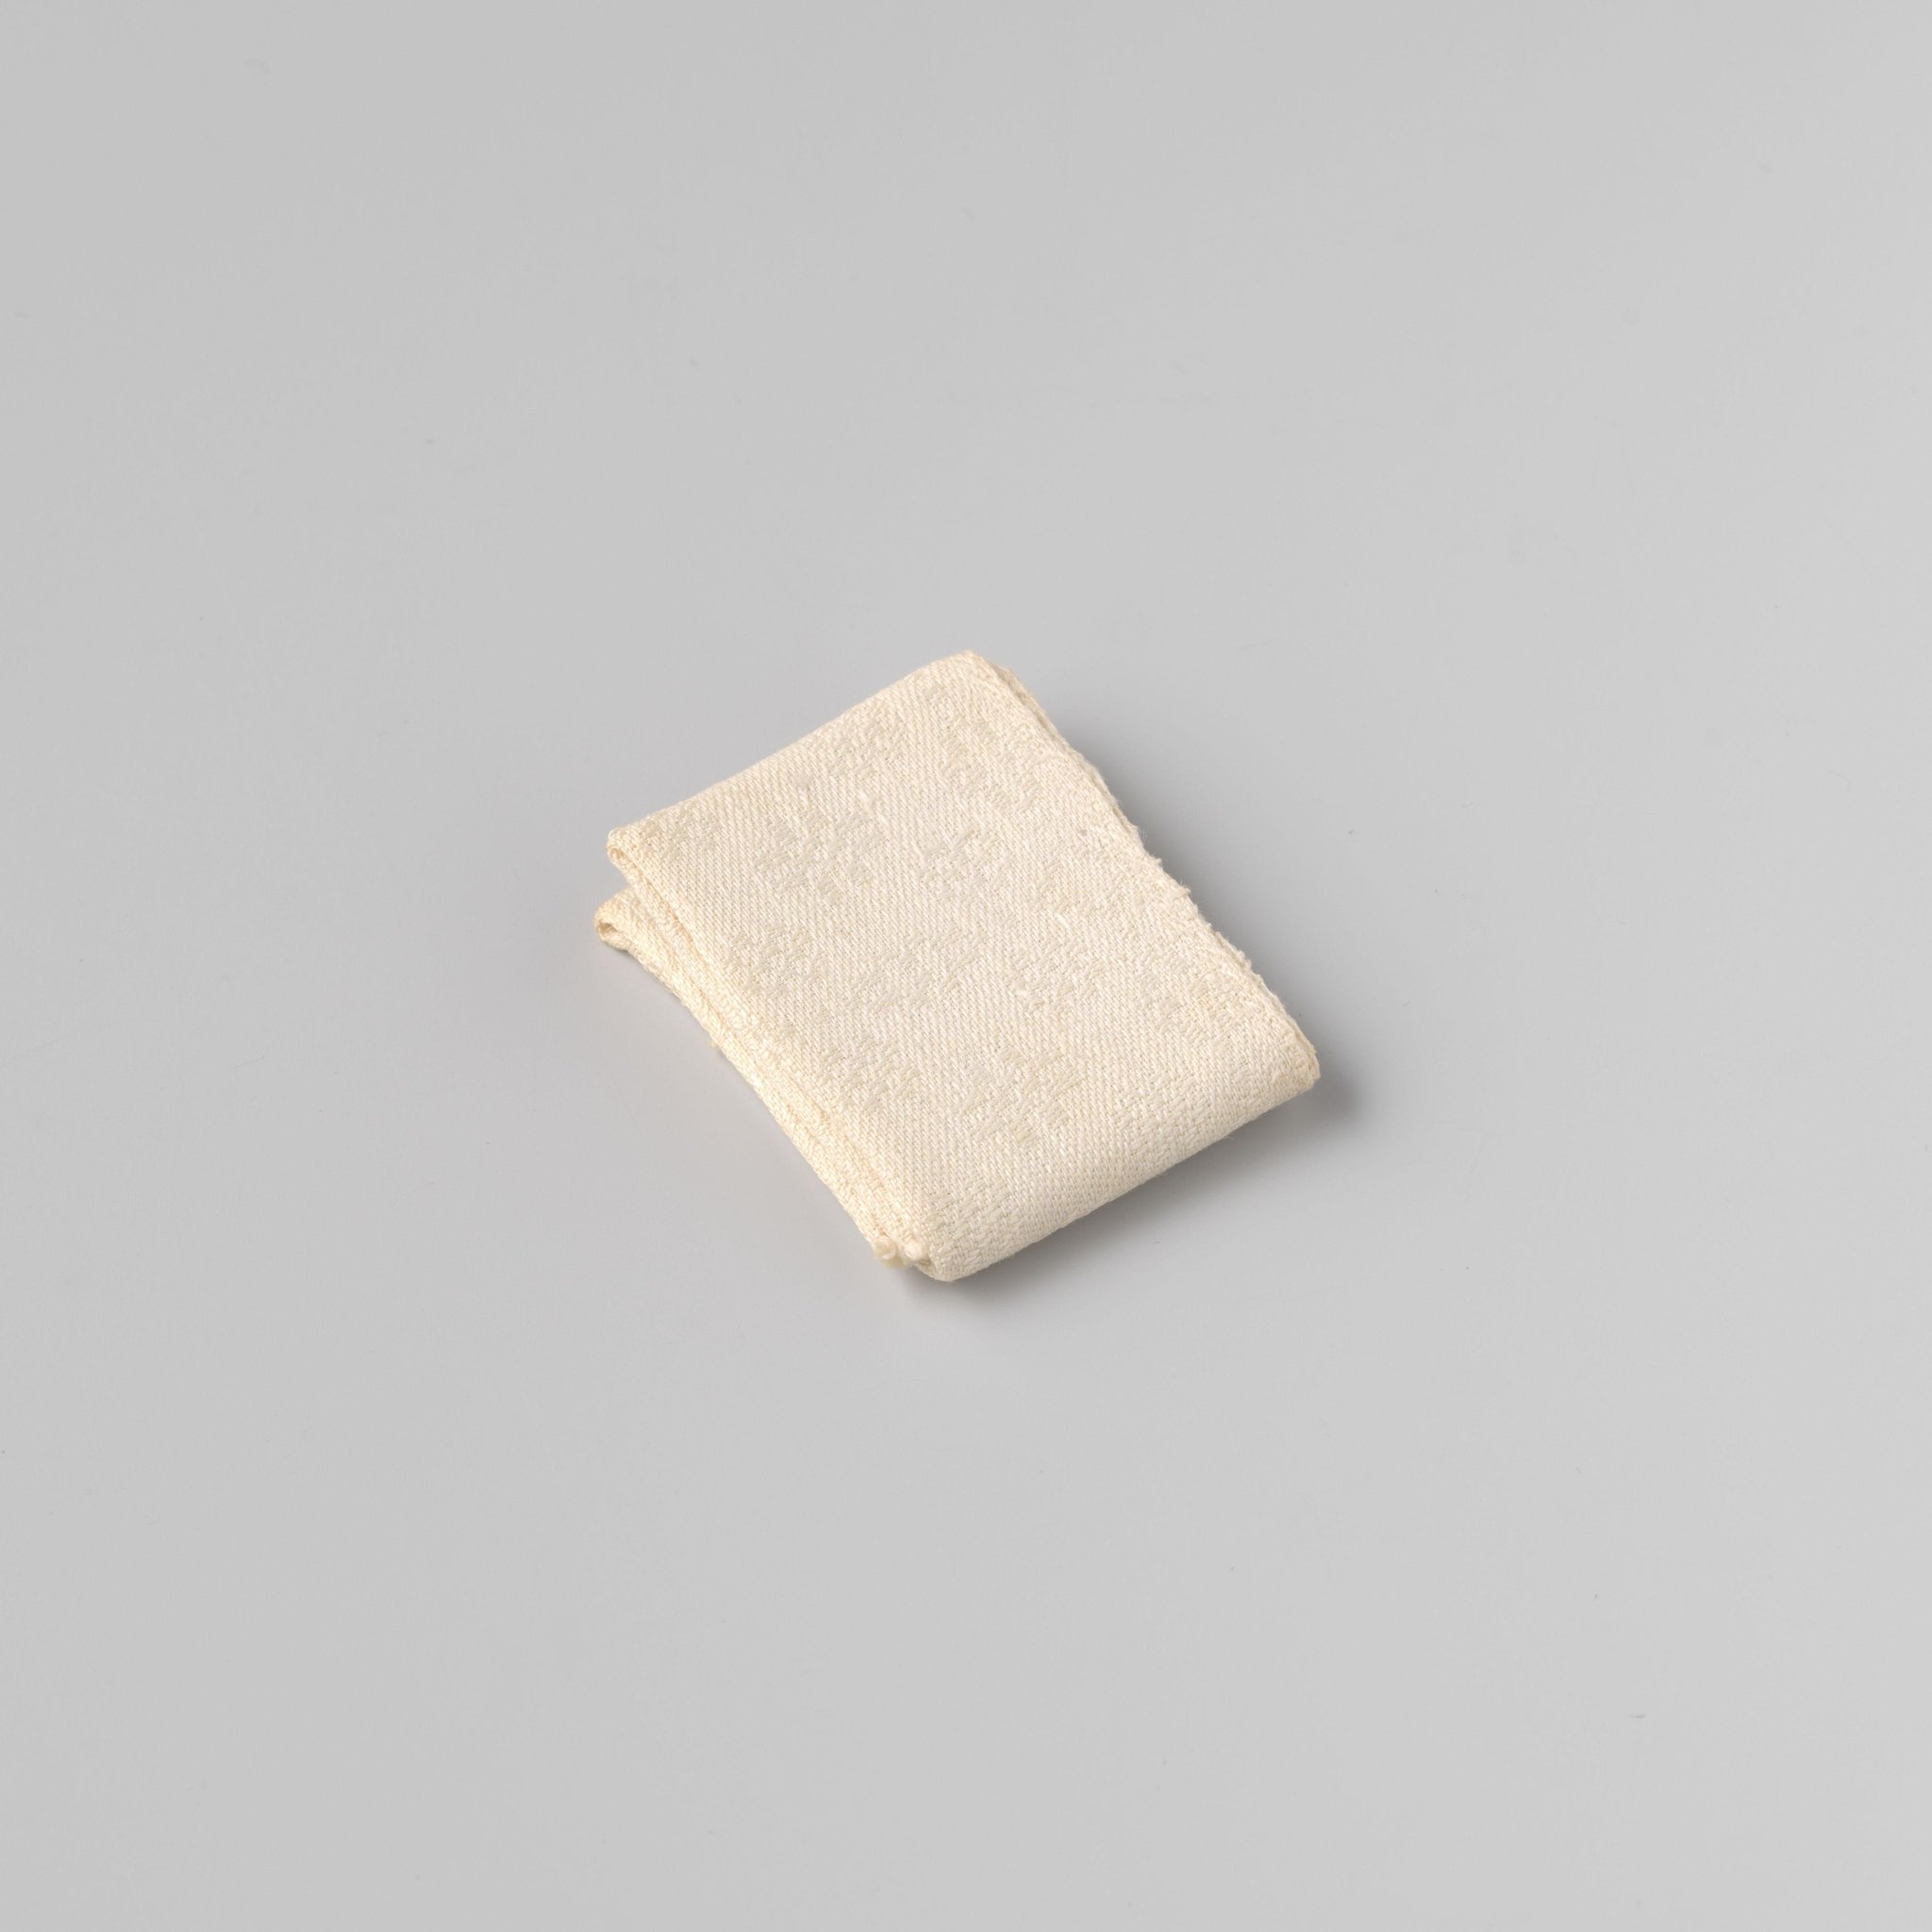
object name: dwaal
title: Linnen servet van damastweefsel met pellenpatroon (motief I), geen zomen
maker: Anonymous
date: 1690-1710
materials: linen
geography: amsterdam